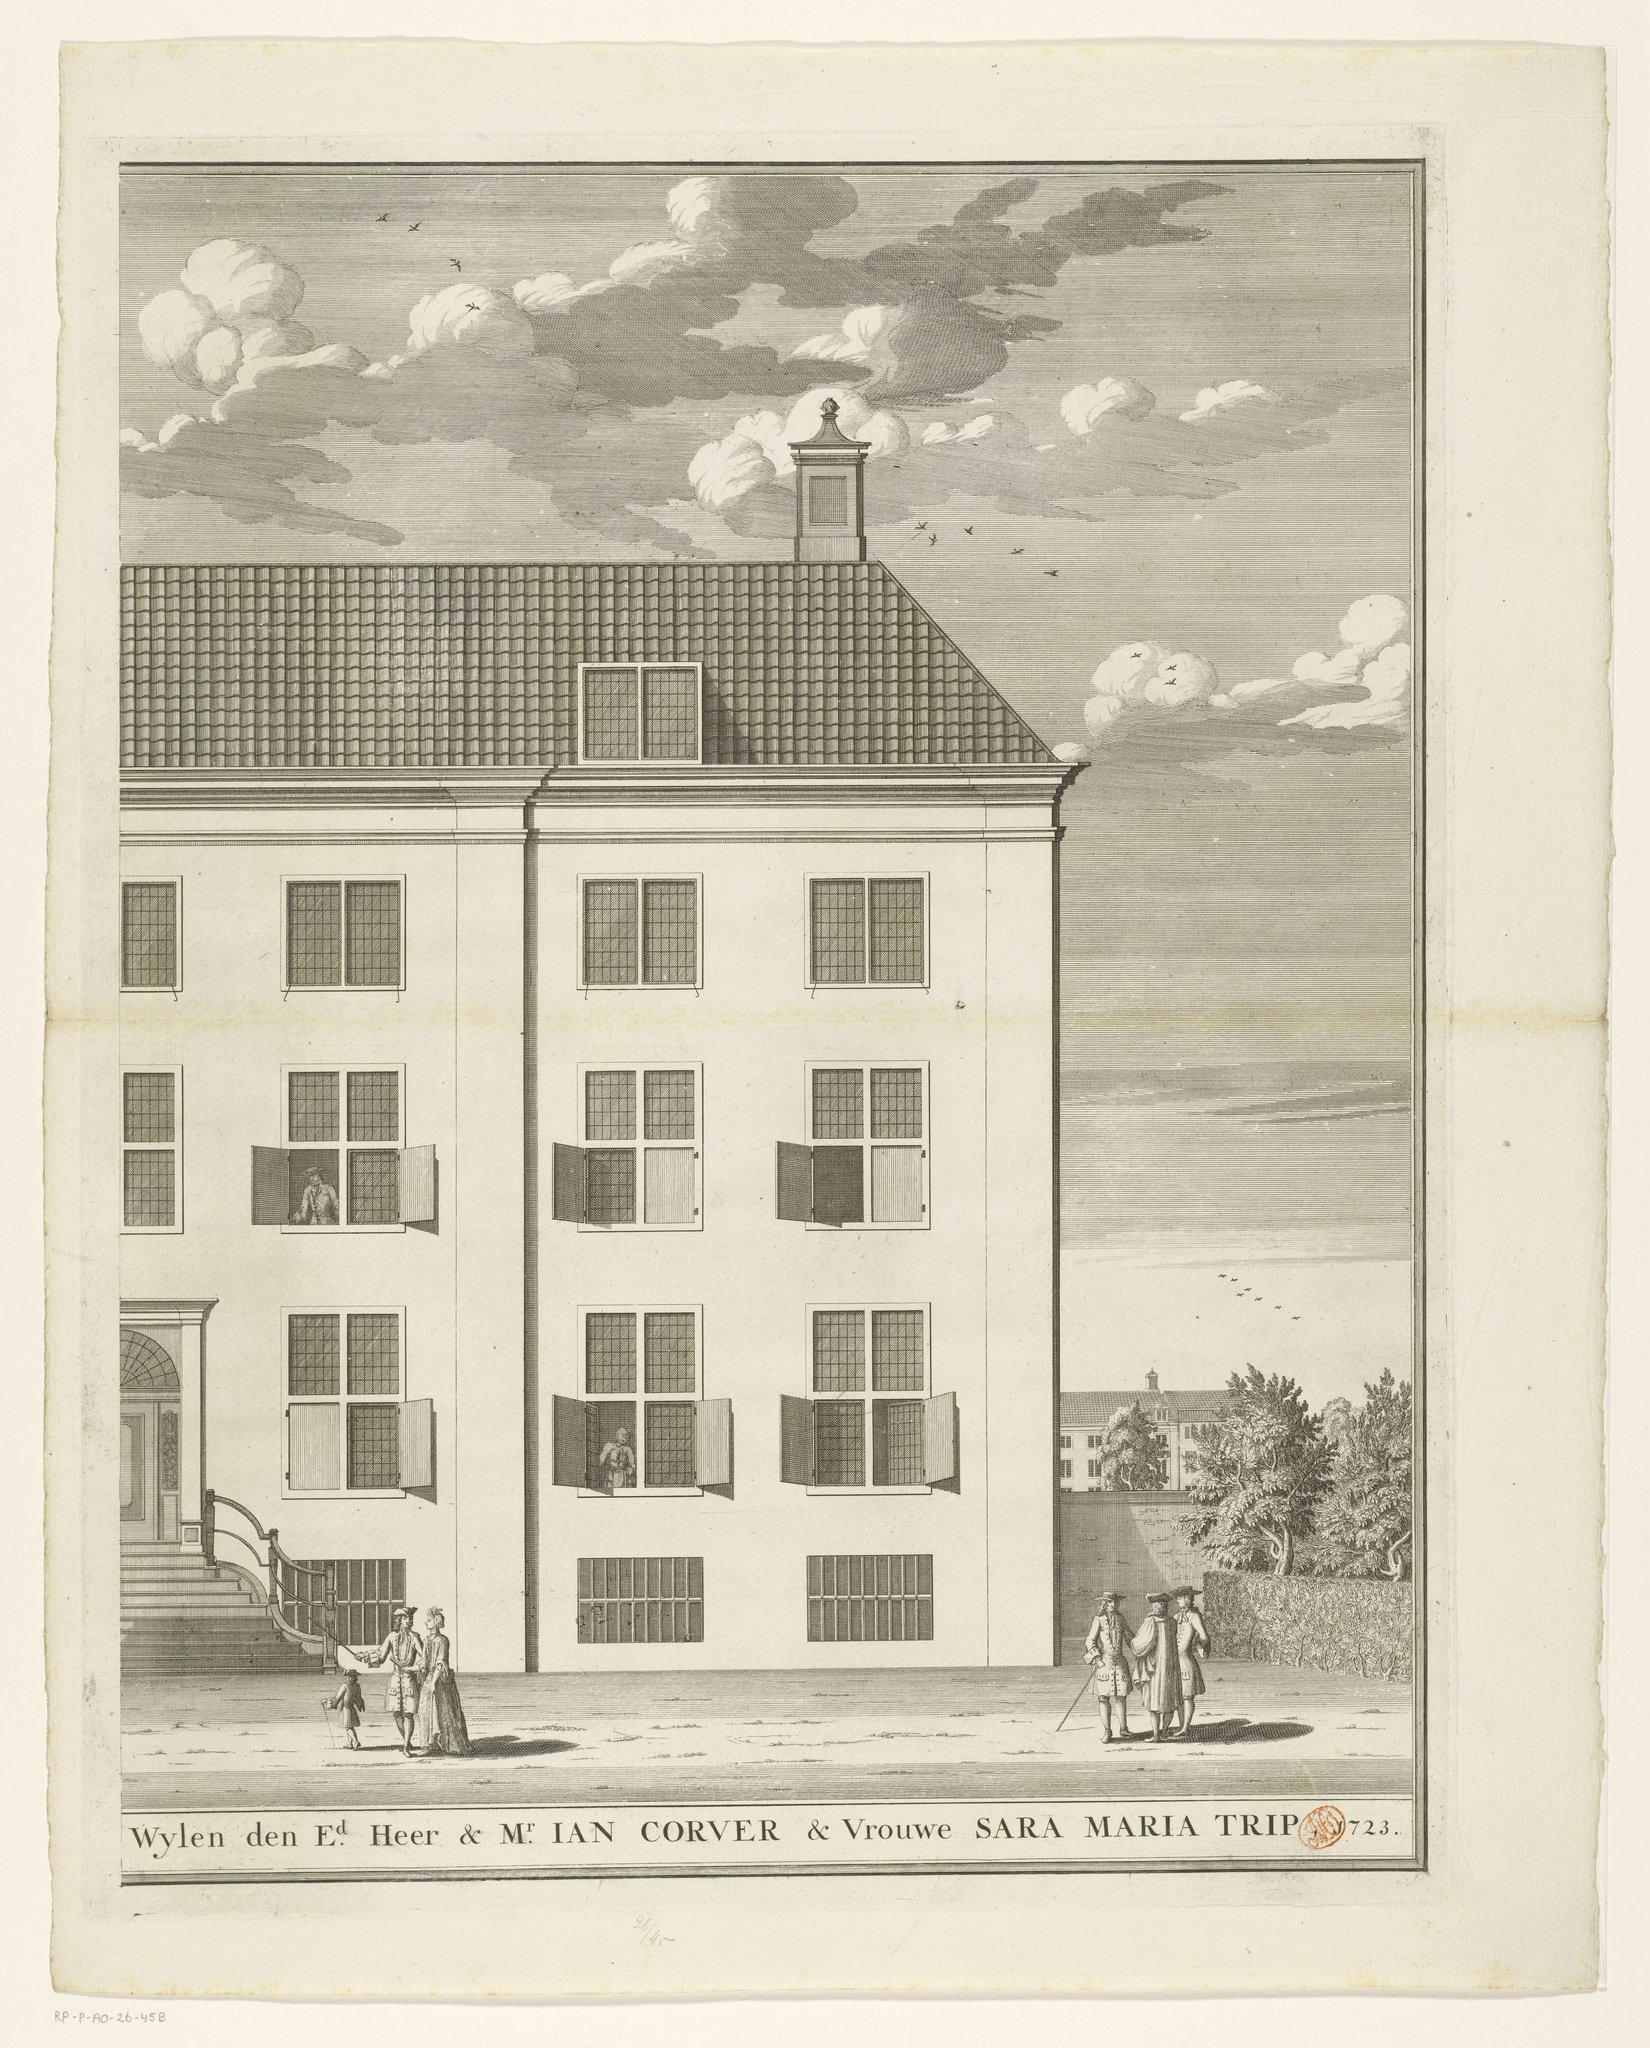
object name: print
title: Het Diaconie gebou gestigt uyt de erffenisse op bevel en ter gedagtenisse van wylen den ed. heer & mr. Ian Corver & vrouwe Sara Maria Trip, 1723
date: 1723-1748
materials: paper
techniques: engraving, etching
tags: alms-house (dutch: 'hofje'), public welfare, old-people's home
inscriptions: collector's mark: Lugt 195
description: Zie ook RP-P-AO-26-45, RP-P-AO-26-46, RP-P-AO-26-47, RP-P-AO-26-48, RP-P-AO-26-49, RP-P-AO-26-50, RP-P-AO-26-51, RP-P-AO-26-52, RP-P-AO-26-53 en RP-P-AO-26-54.